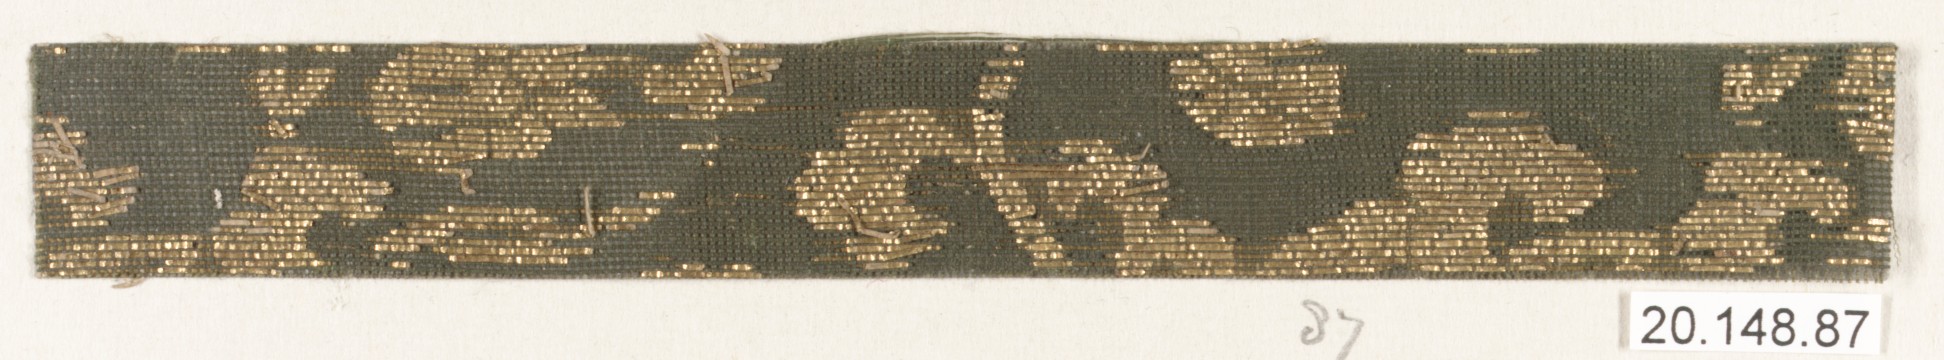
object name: piece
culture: japanese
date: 1501-1600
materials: silk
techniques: compound weave